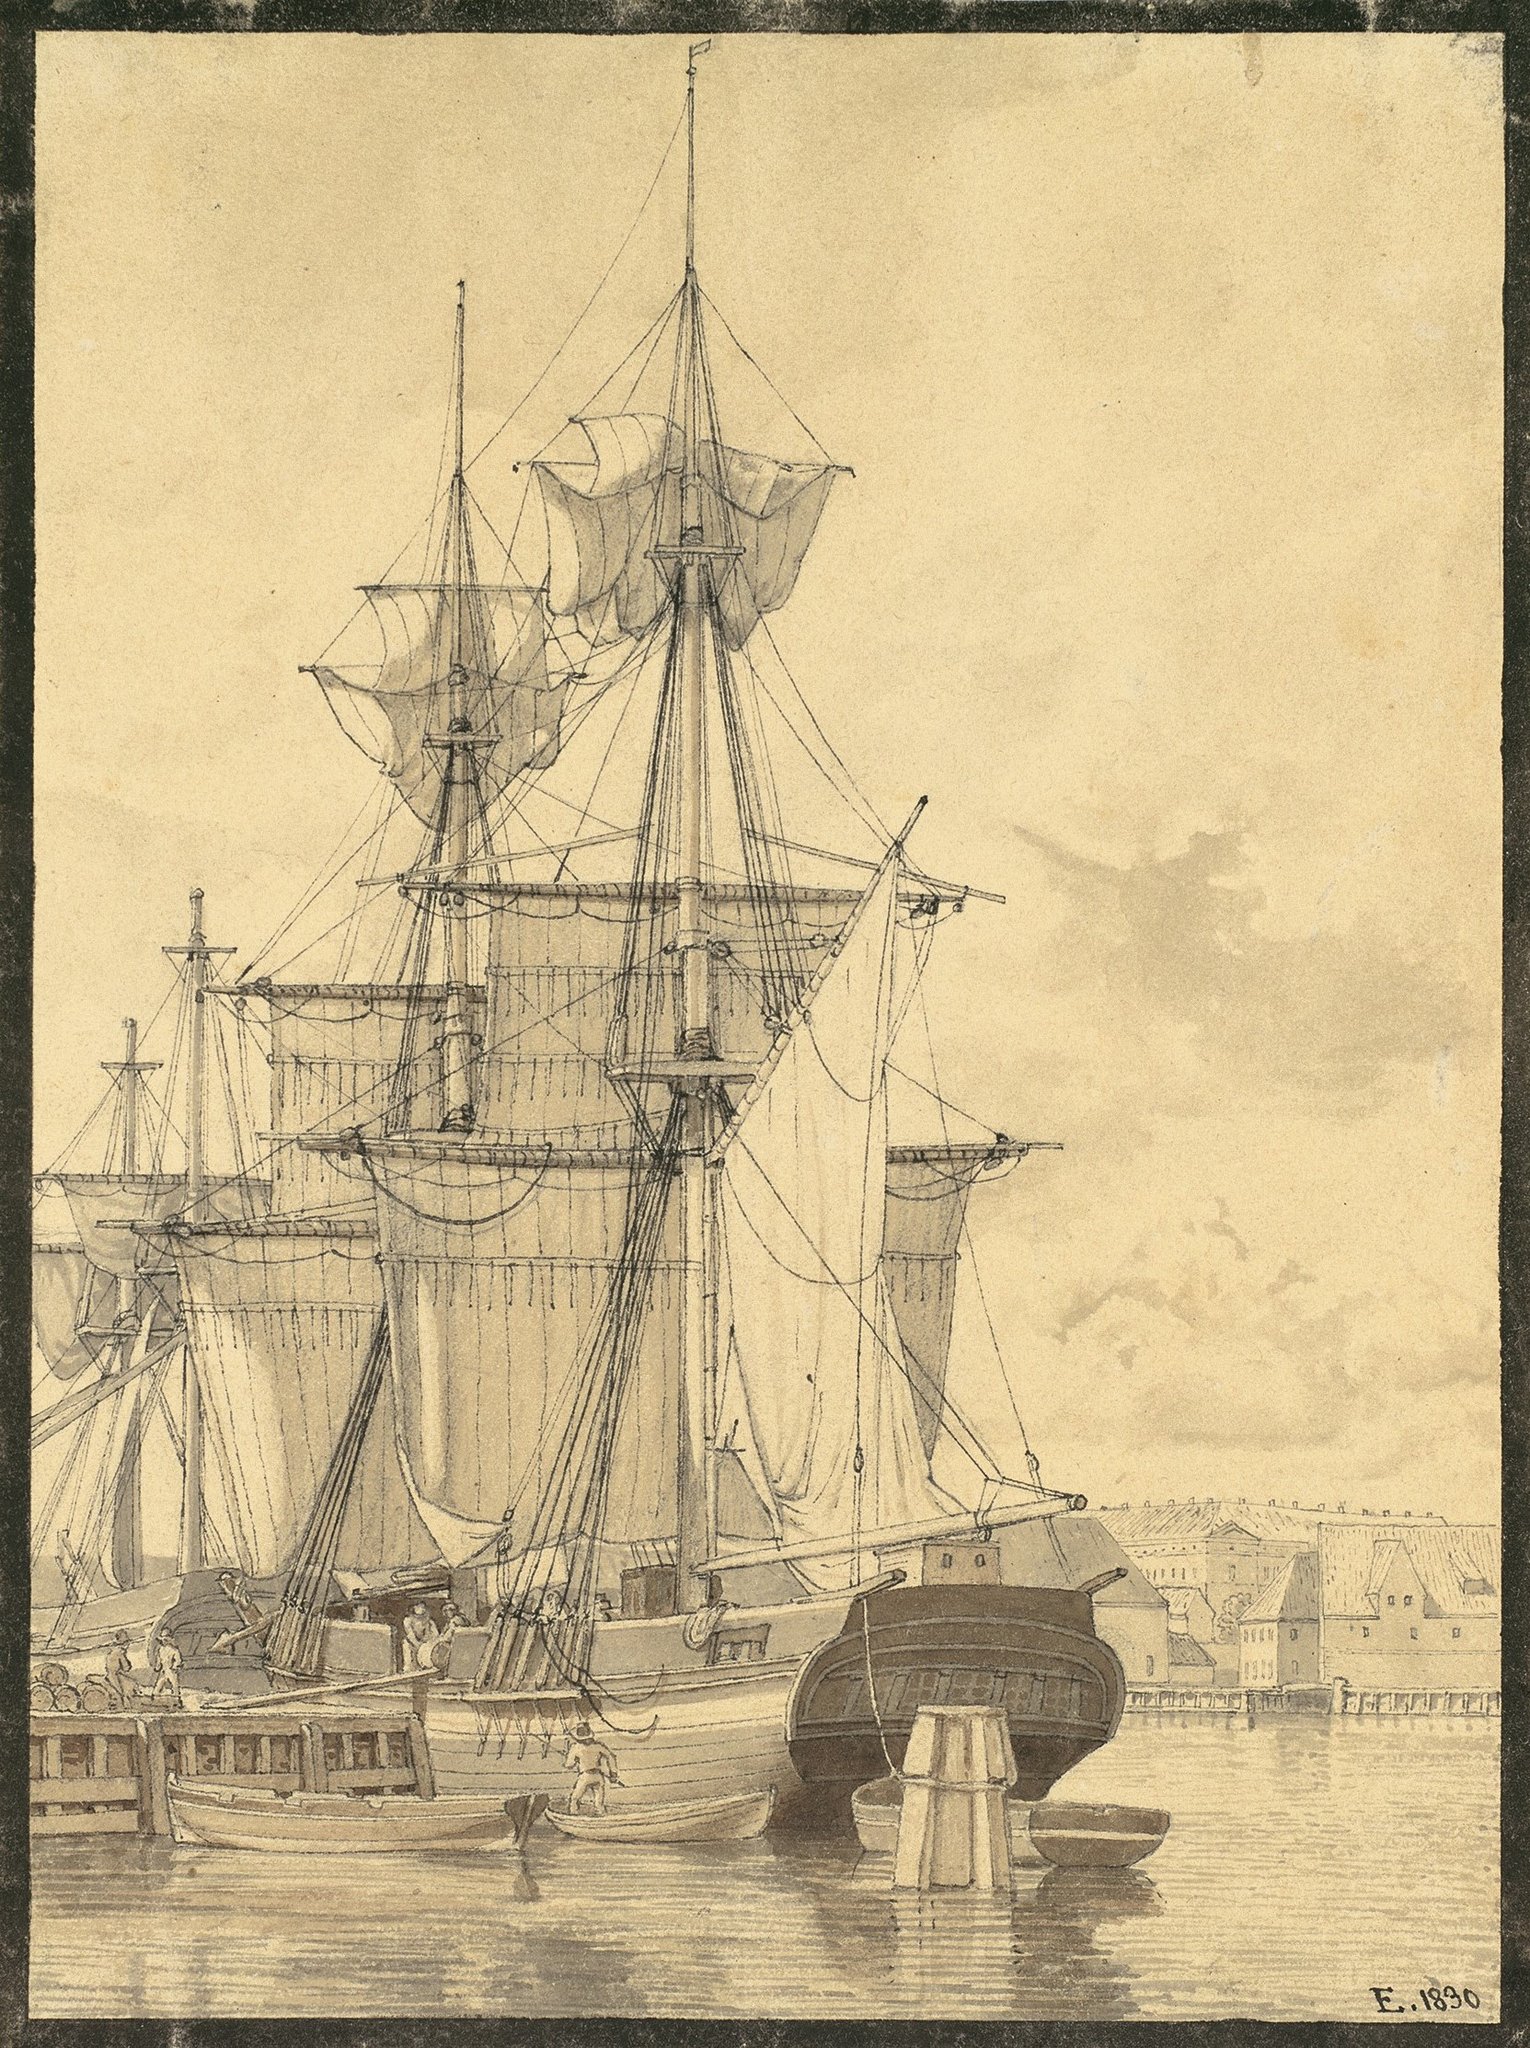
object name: drawing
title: Sailing Vessels at Wilders Plads, Copenhagen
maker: christoffer wilhelm eckersberg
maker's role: artist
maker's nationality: danish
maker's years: 1783-1853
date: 1830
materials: ink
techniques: brush, pen, wash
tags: ships